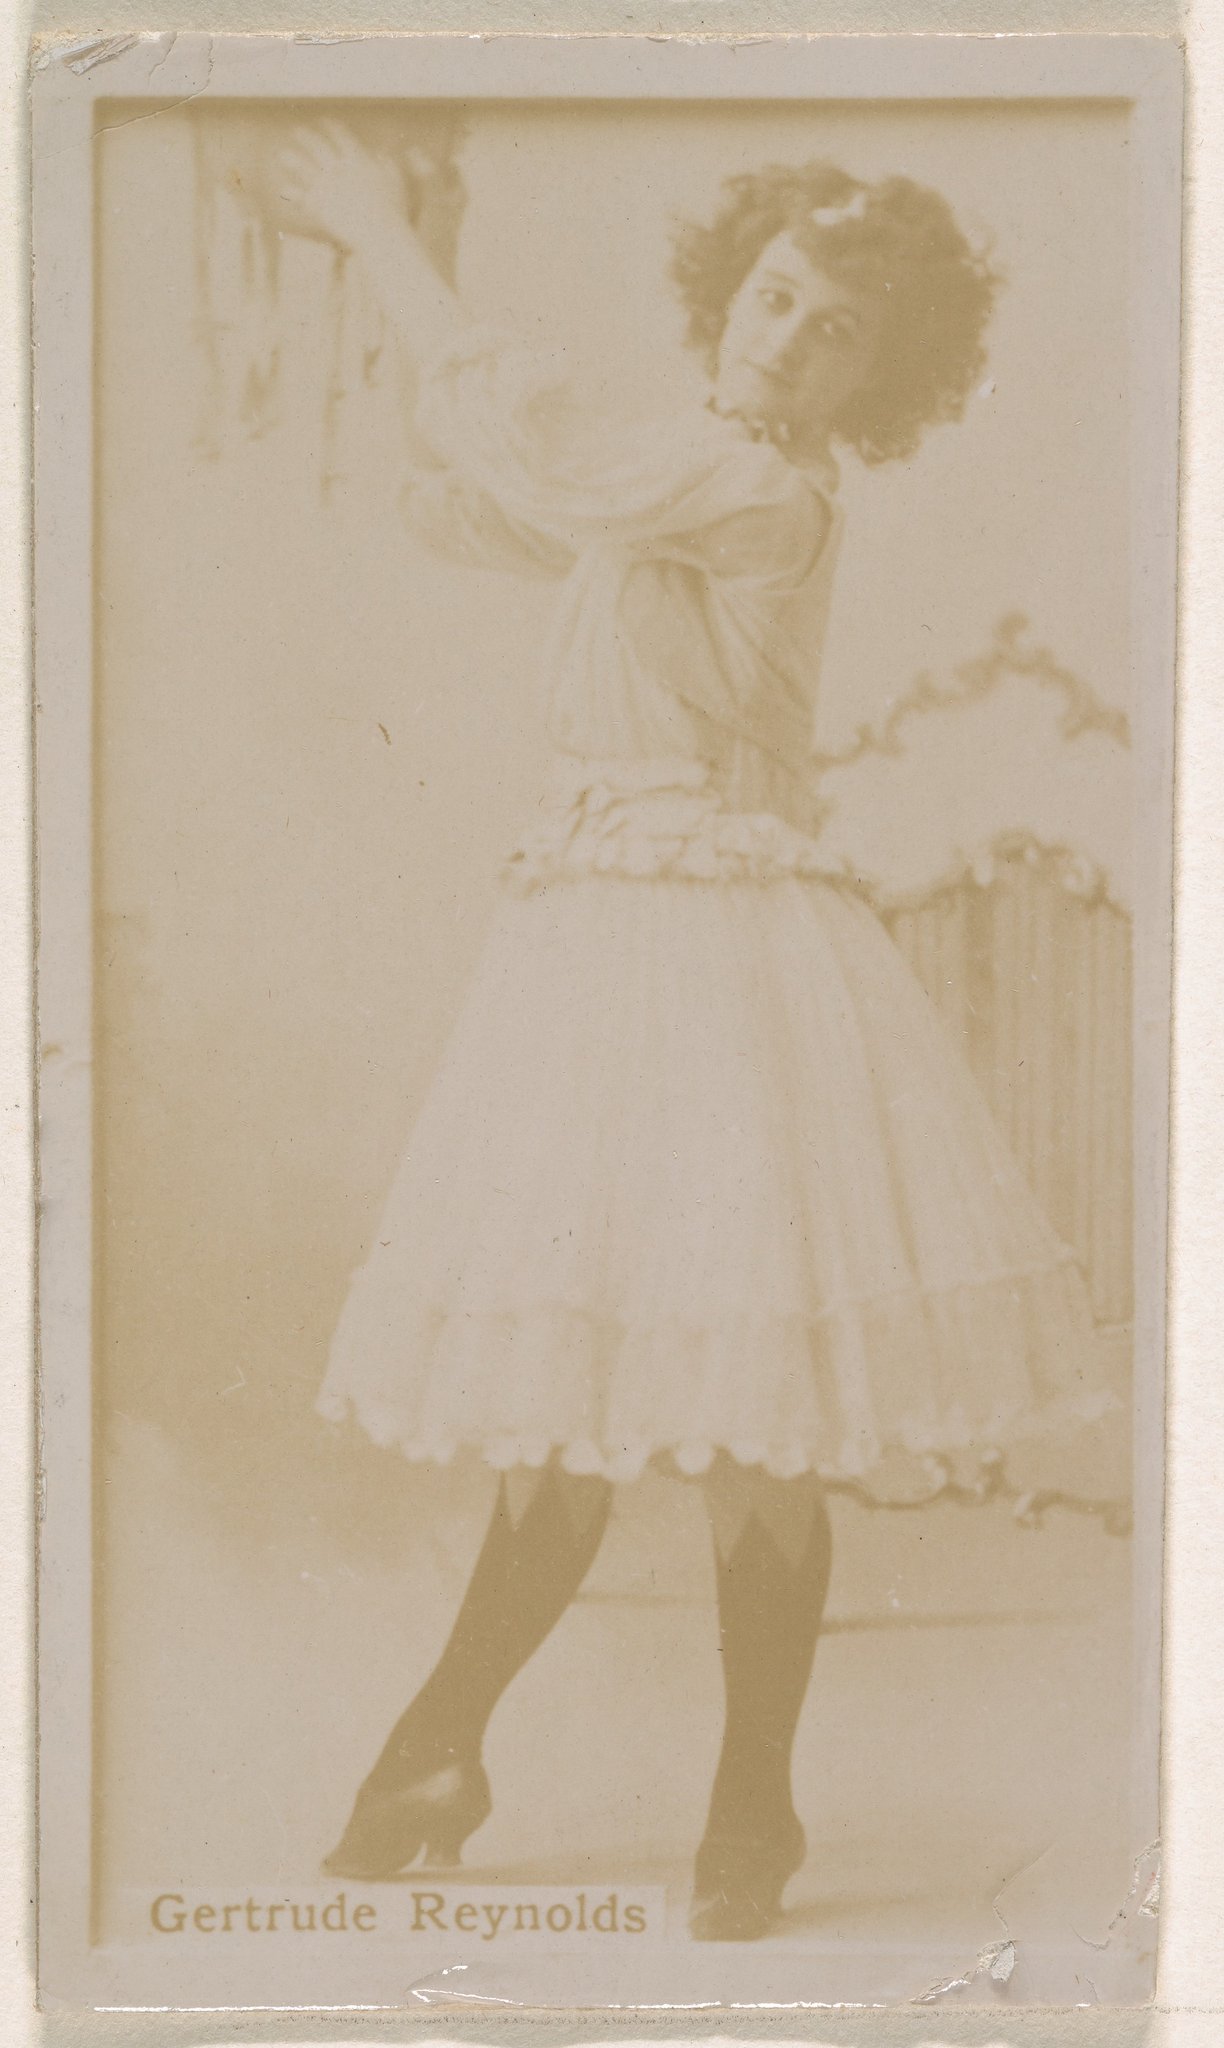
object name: photograph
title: Gertrude Reynolds, from the Actresses series (N245) issued by Kinney Brothers to promote Sweet Caporal Cigarettes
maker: kinney brothers tobacco company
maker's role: publisher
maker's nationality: american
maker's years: 1869-2011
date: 1890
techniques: albumen silver print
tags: portraits,women,actresses